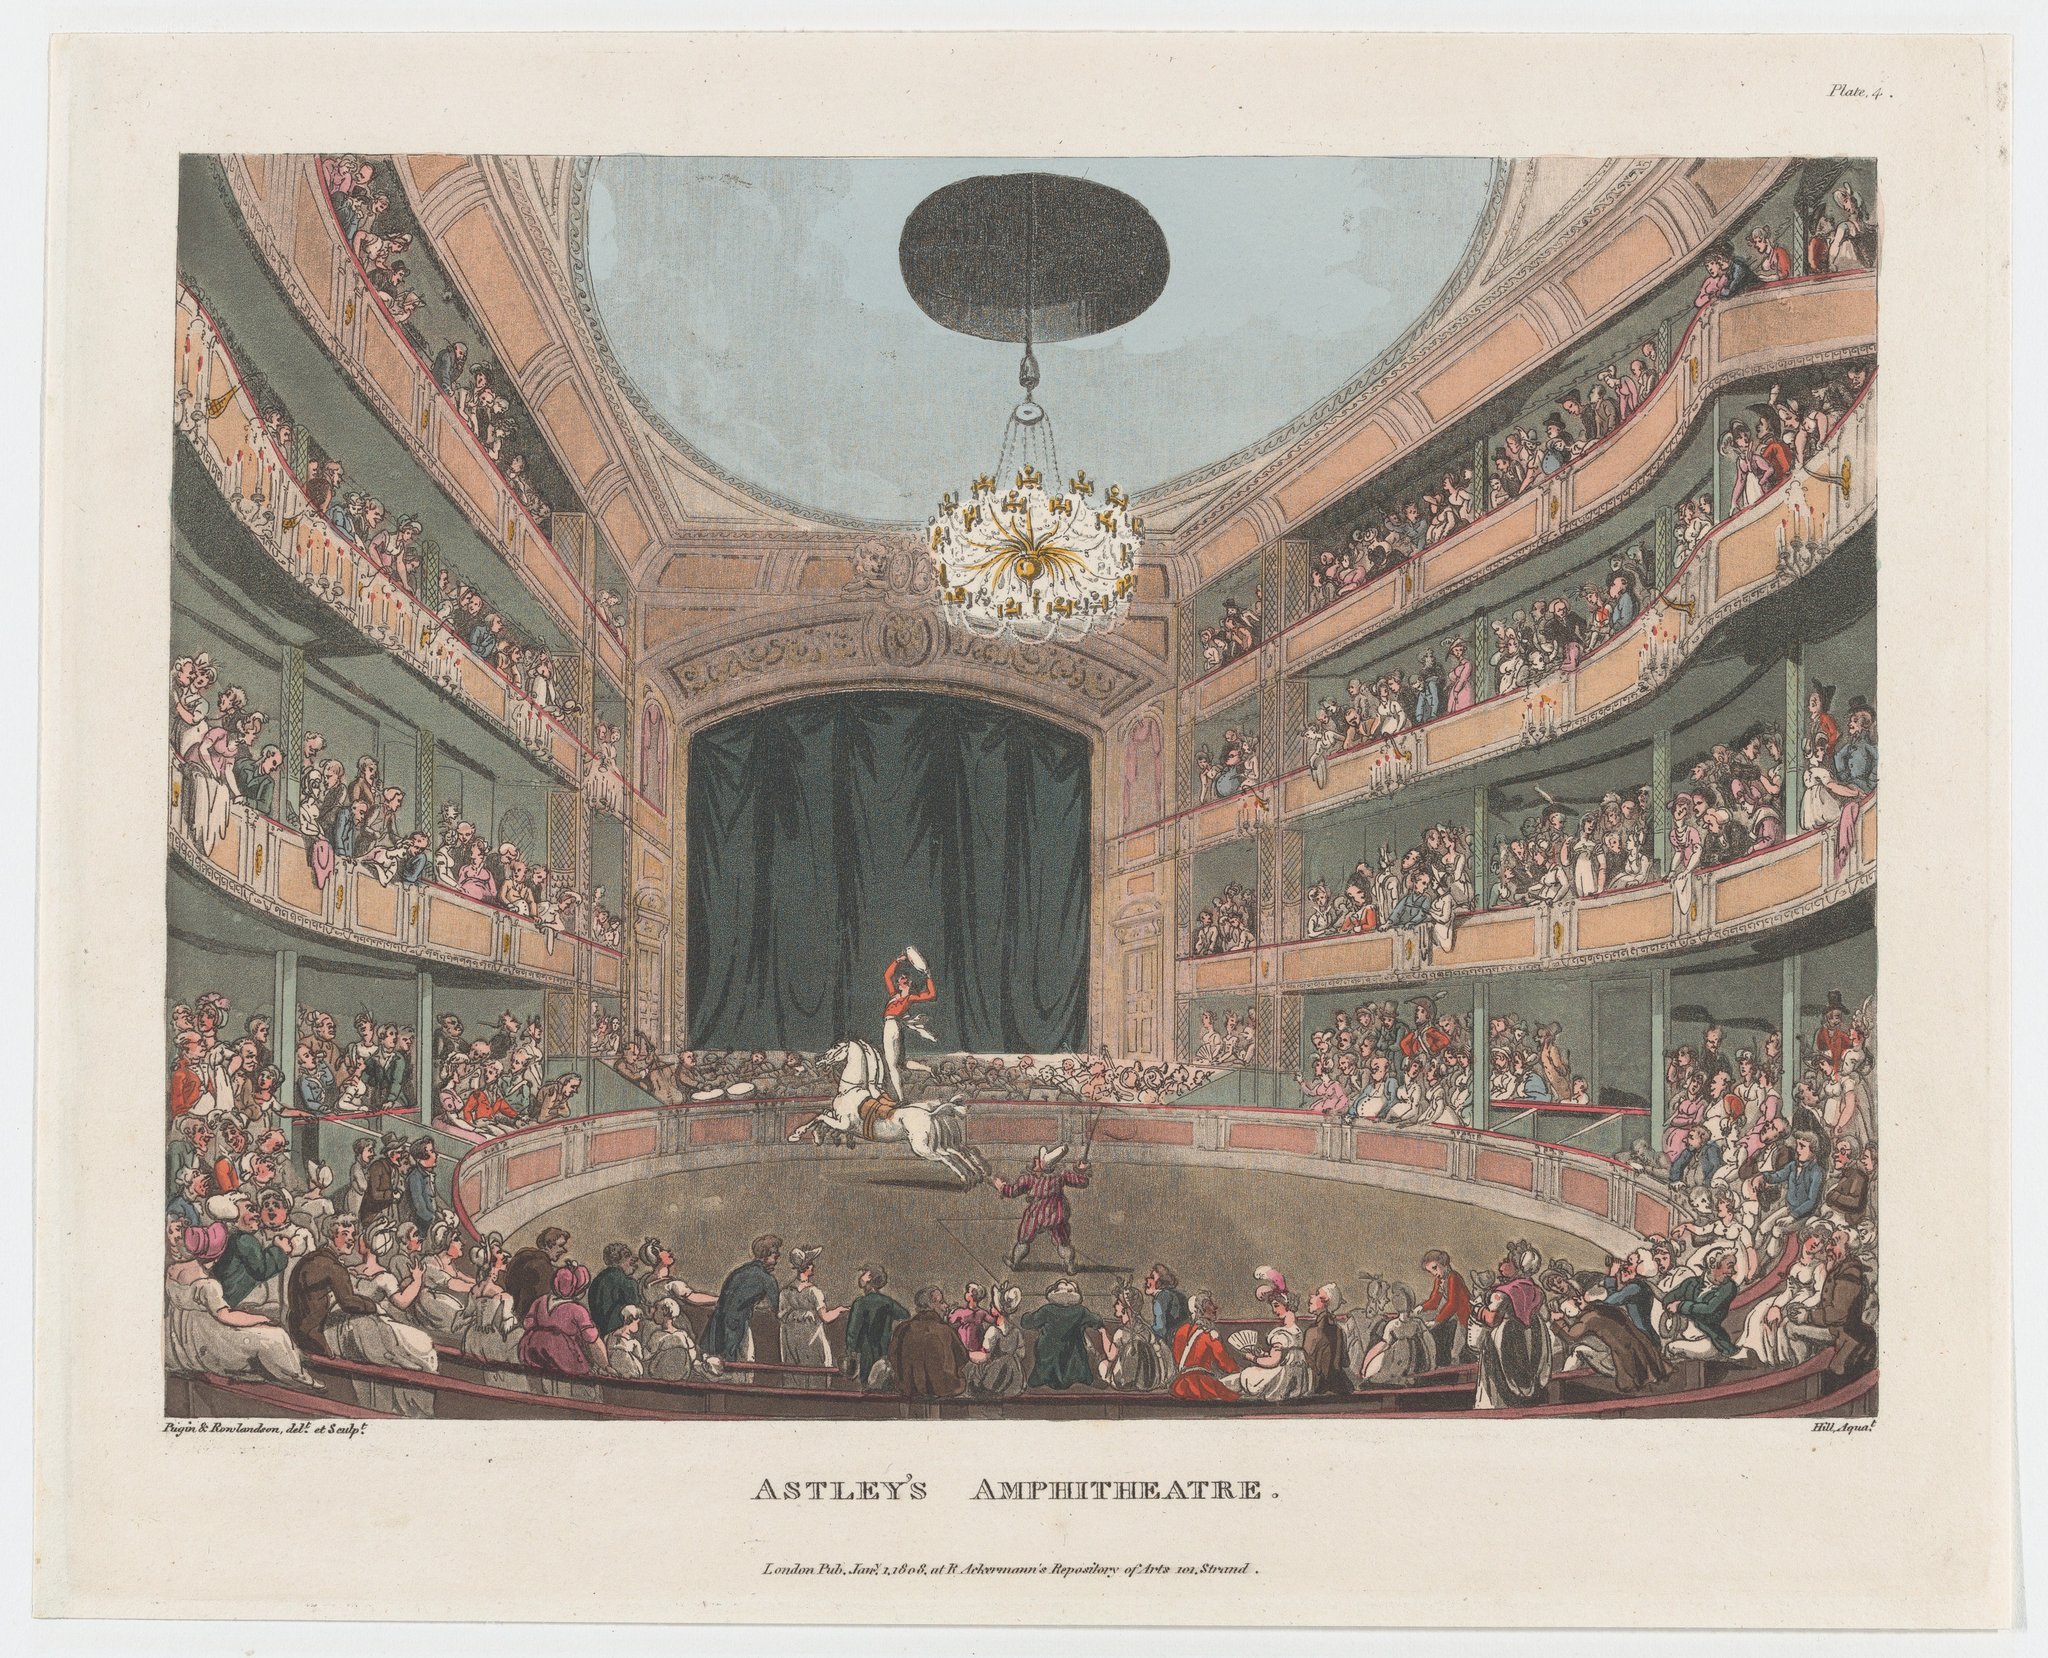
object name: print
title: Astley's Amphitheatre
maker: thomas rowlandson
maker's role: artist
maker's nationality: british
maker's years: 1757-1827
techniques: aquatint, etching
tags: performance,theatre,spectators,horses,london